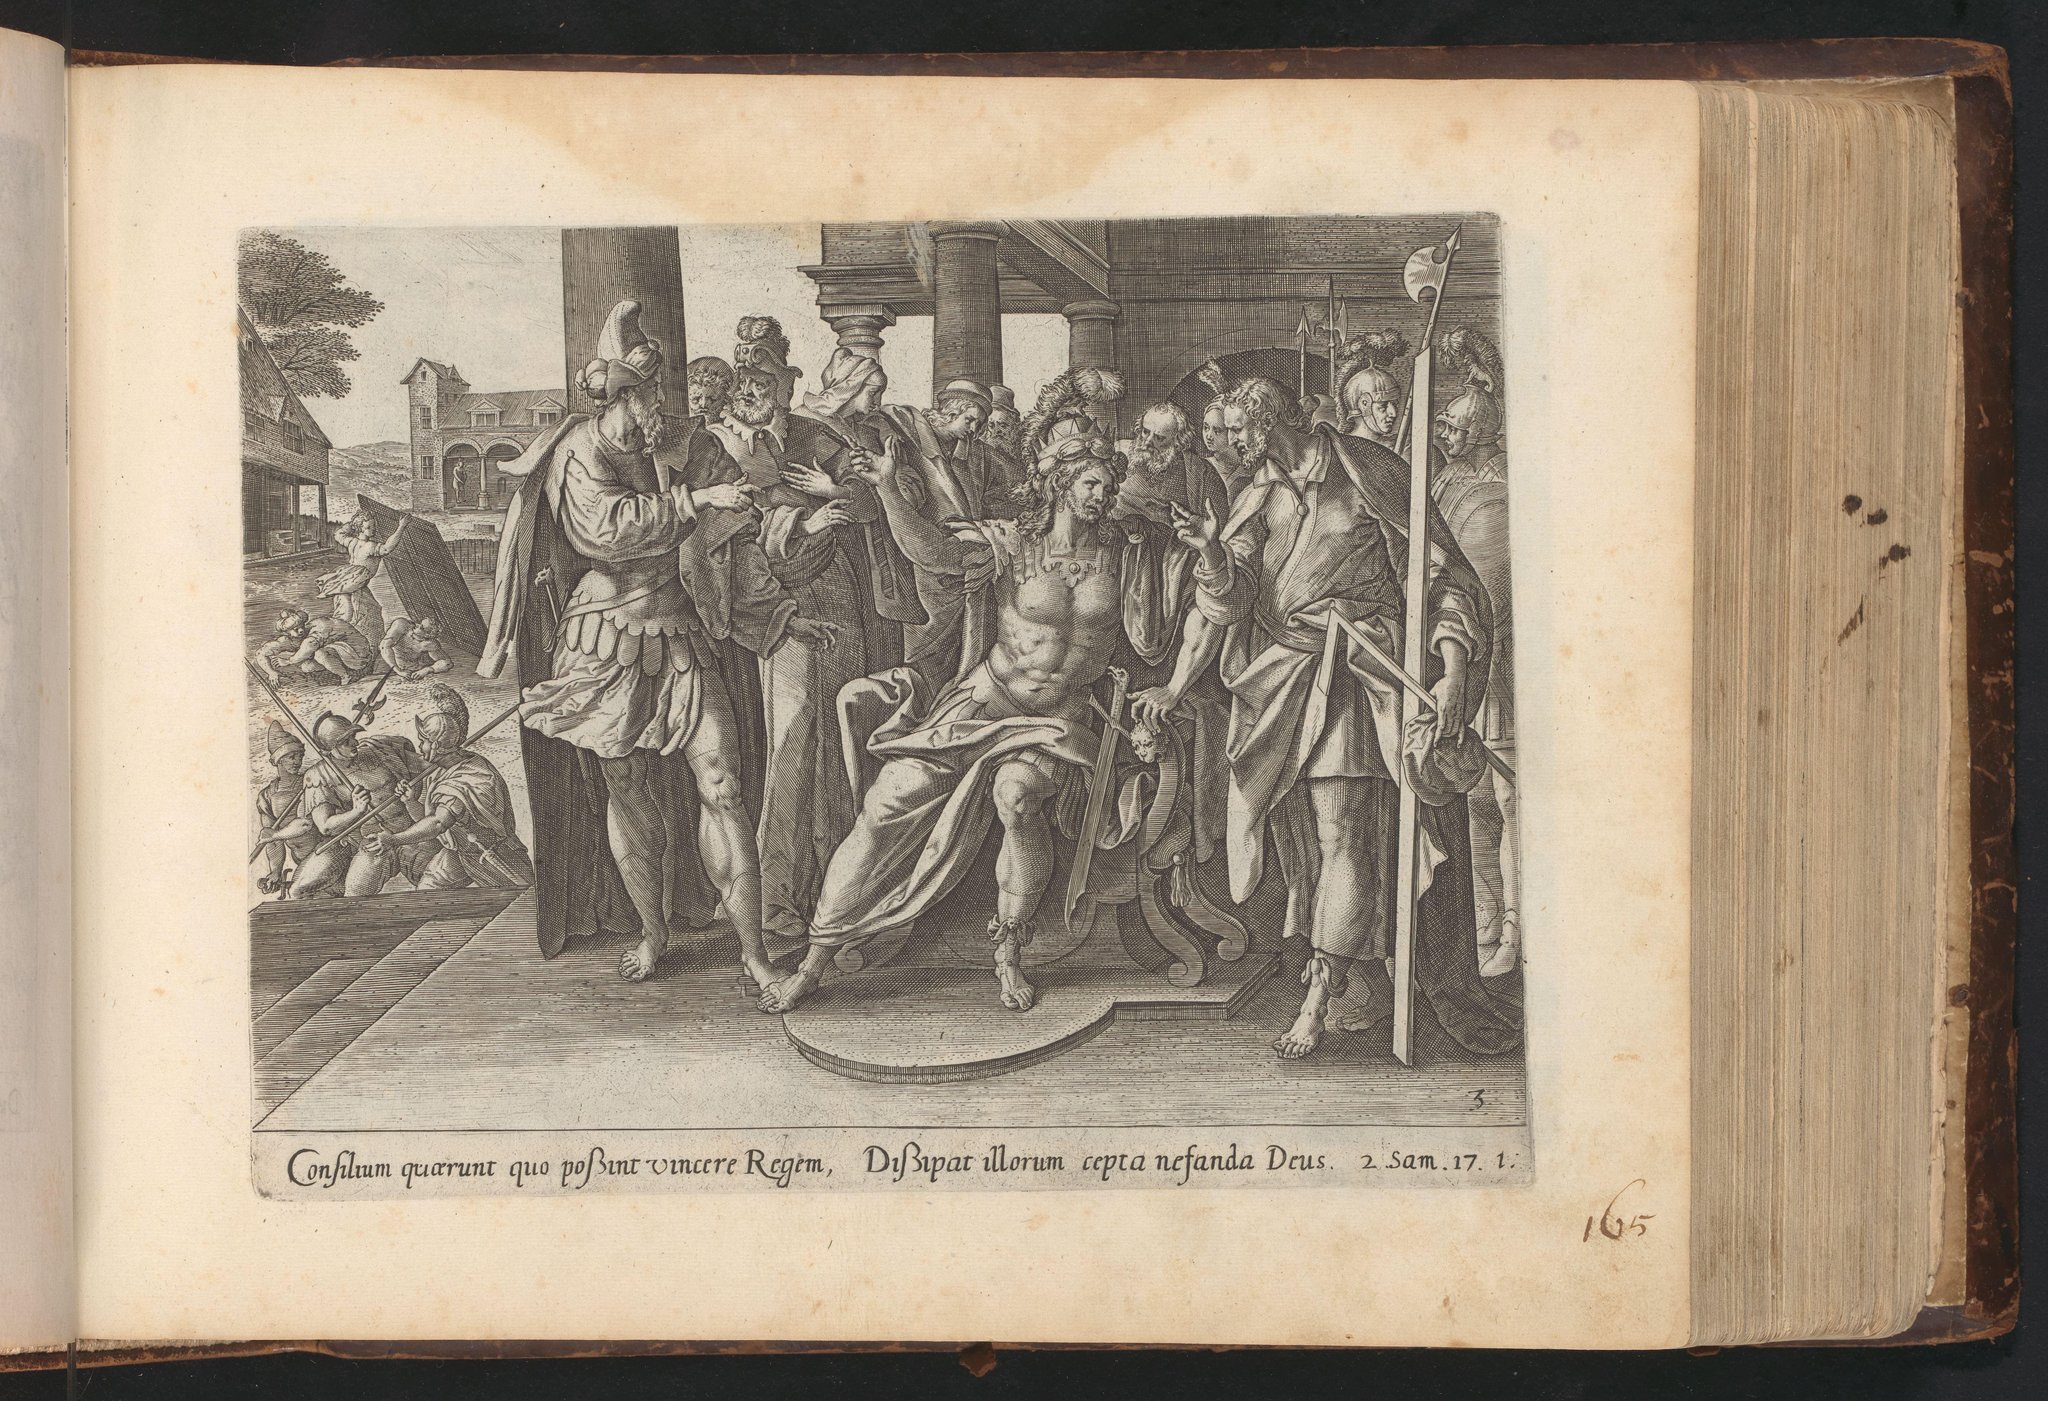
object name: print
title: Achitofel en Chusai bij Absalom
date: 1585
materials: paper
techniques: engraving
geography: alkmaar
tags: pursued by absalom's soldiers ahimaaz and jonathan hide in a pit in a house at baharim; a woman spreads a cover with corn over the pit, hushai called for counsel, absalom takes counsel with ahitophel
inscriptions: number: ‘165’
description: Achitofel en de Arkiet Chusai adviseren Absalom over het krijgsplan tegen koning David. Op de achtergrond verstoppen Jonatan en Achimaäs, die het nieuws over het plan aan koning David zullen overbrengen, zich in een put op het erf van het huis van een man uit Bachurim. Diens vrouw legt een luik over de opening van de put, zodat er niets te zien is. Onder de voorstelling een verwijzing in het Latijn naar de Bijbeltekst in 2 Sam. 17:1. Deze prent maakt deel uit van een album.